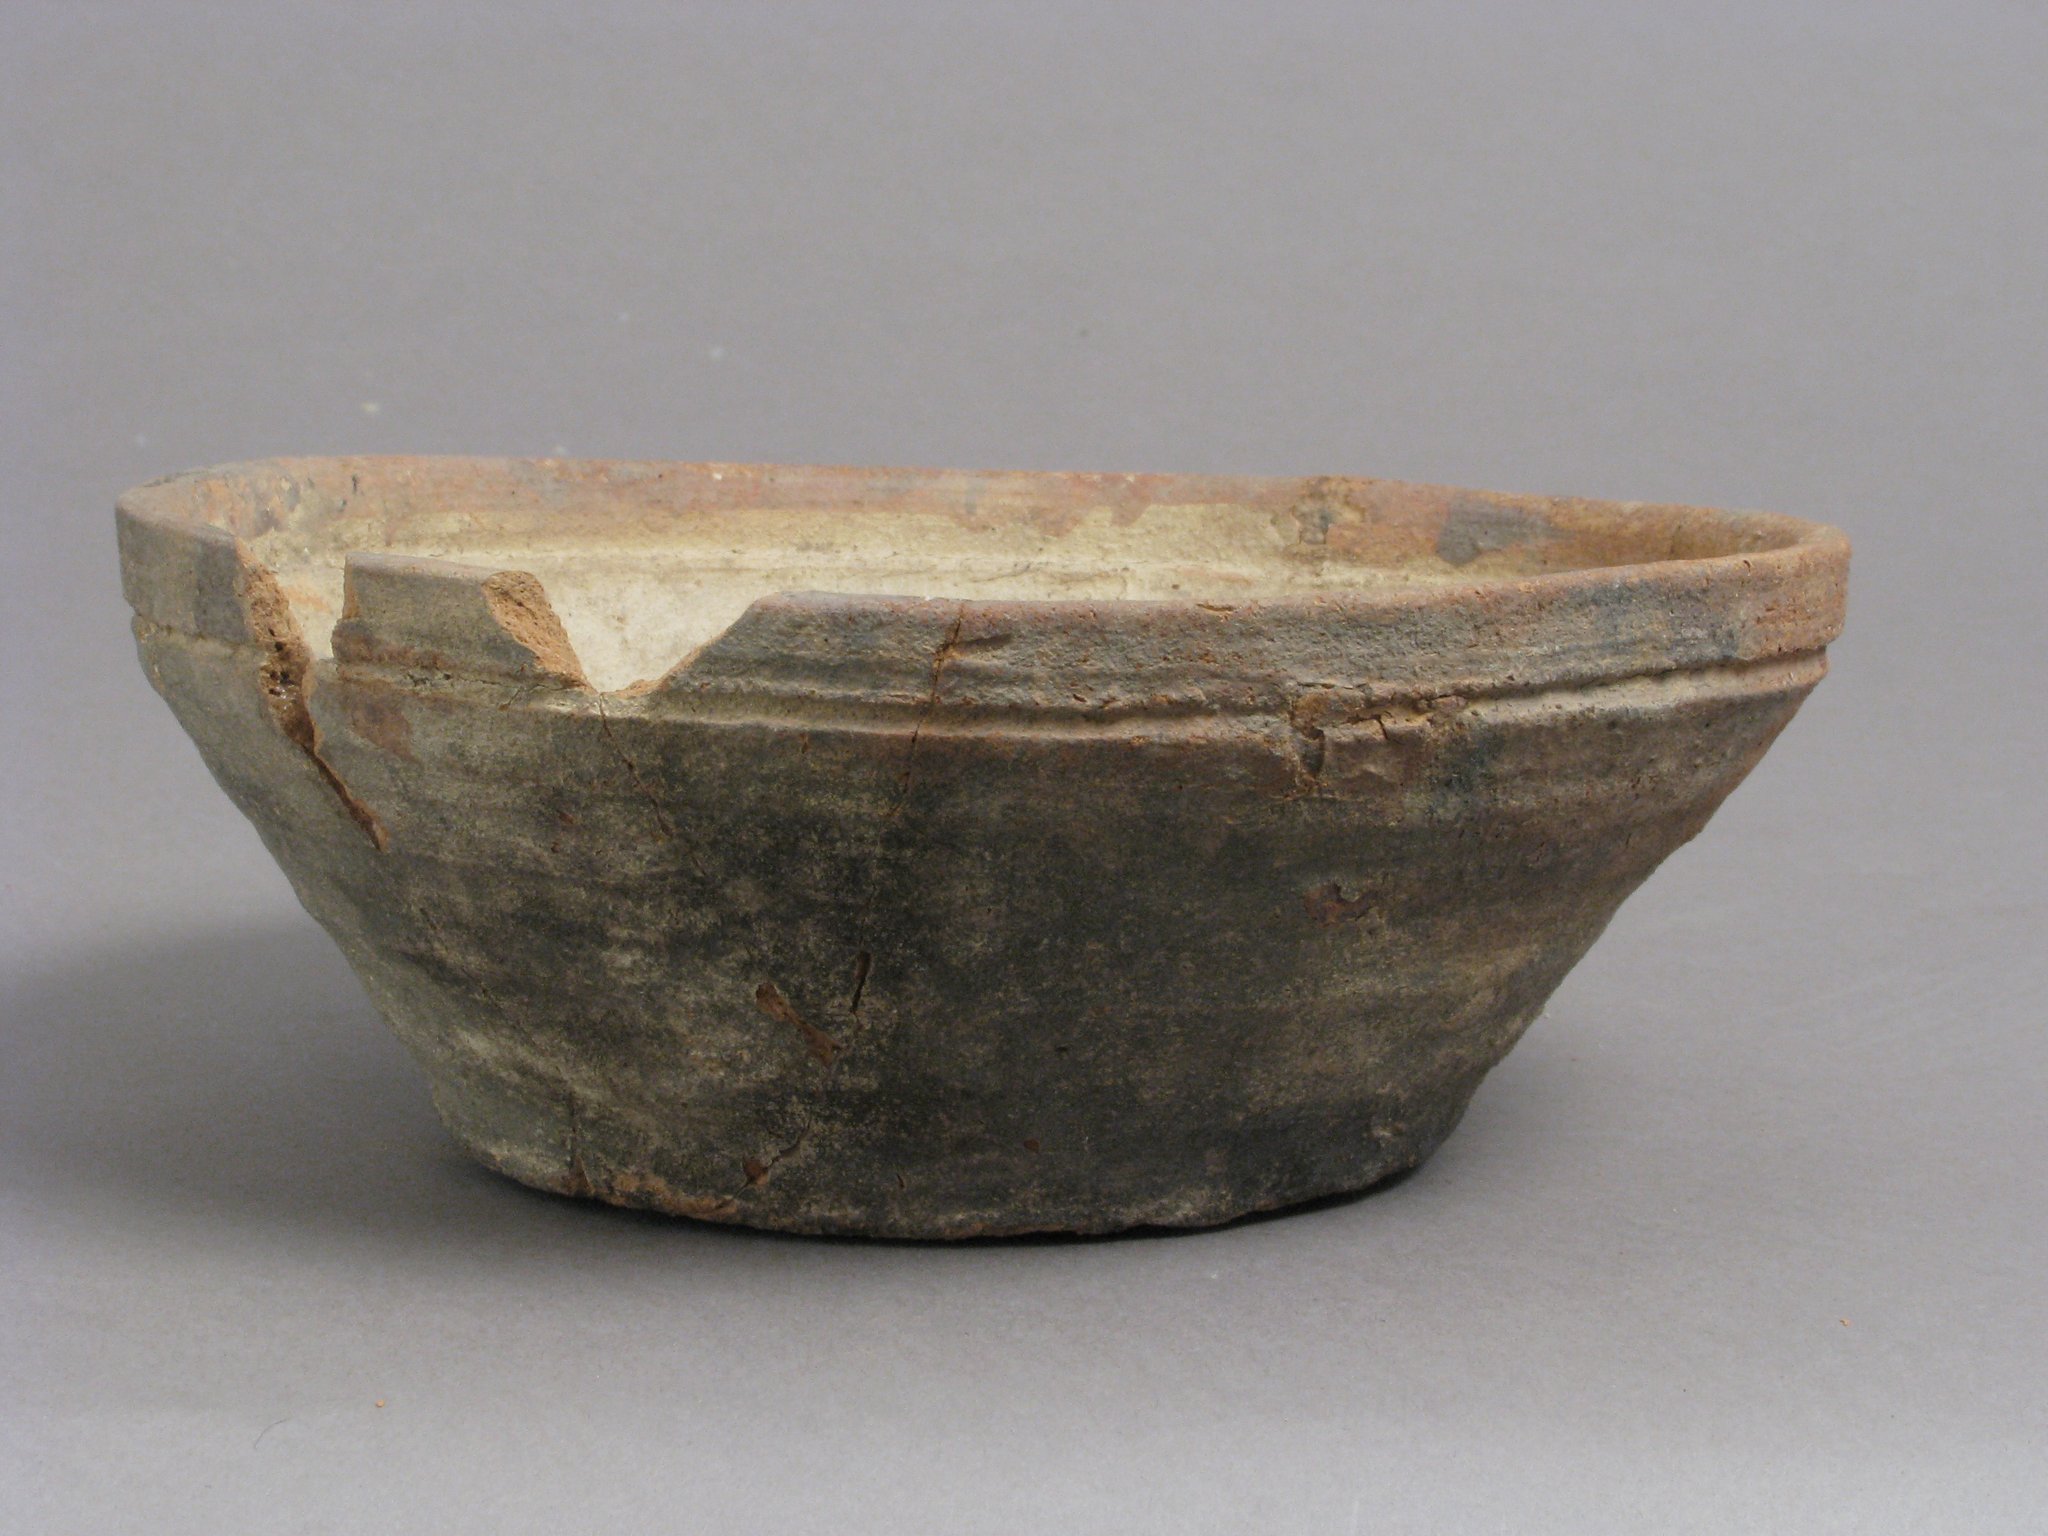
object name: bowl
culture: coptic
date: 301-700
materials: earthenware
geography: egypt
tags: bowls